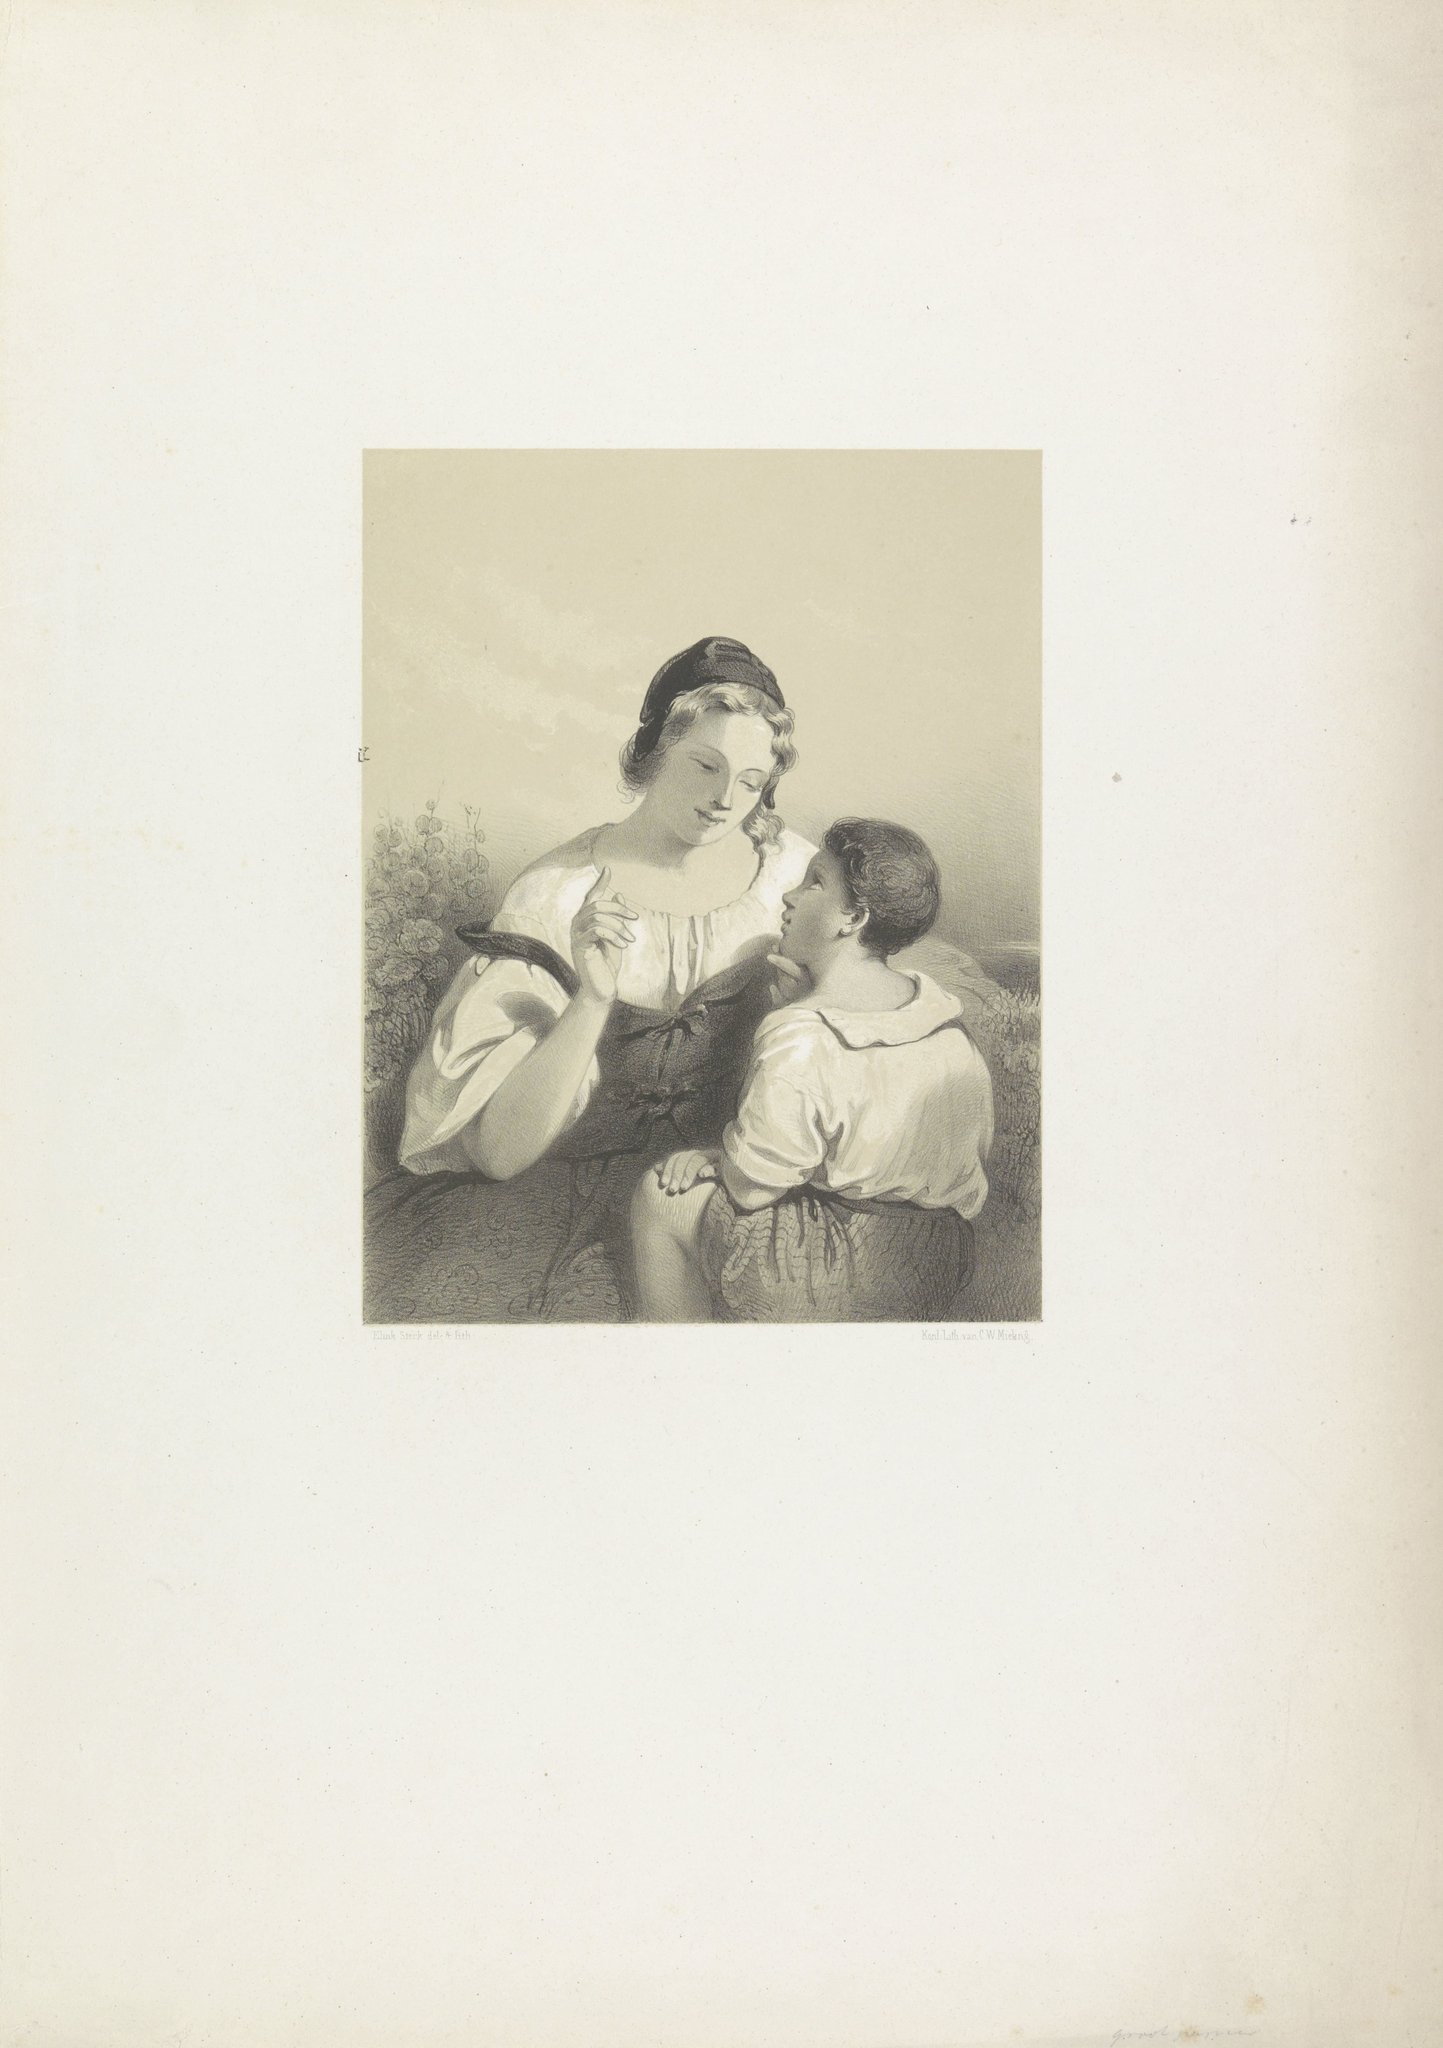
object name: print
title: Meisje spreekt jongen toe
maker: isaac cornelis elink sterk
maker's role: print maker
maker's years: 1808-1871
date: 1818-1871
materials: paper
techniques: tone lithography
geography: the hague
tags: adolescent, young woman, maiden, boy (child between toddler and youth), speaking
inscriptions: collector's mark: Lugt 2228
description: Het meisje en de jongen zitten in een landschap. Het meisje maakt met haar rechterhand een spreekgebaar, de jongen kijkt naar haar op.